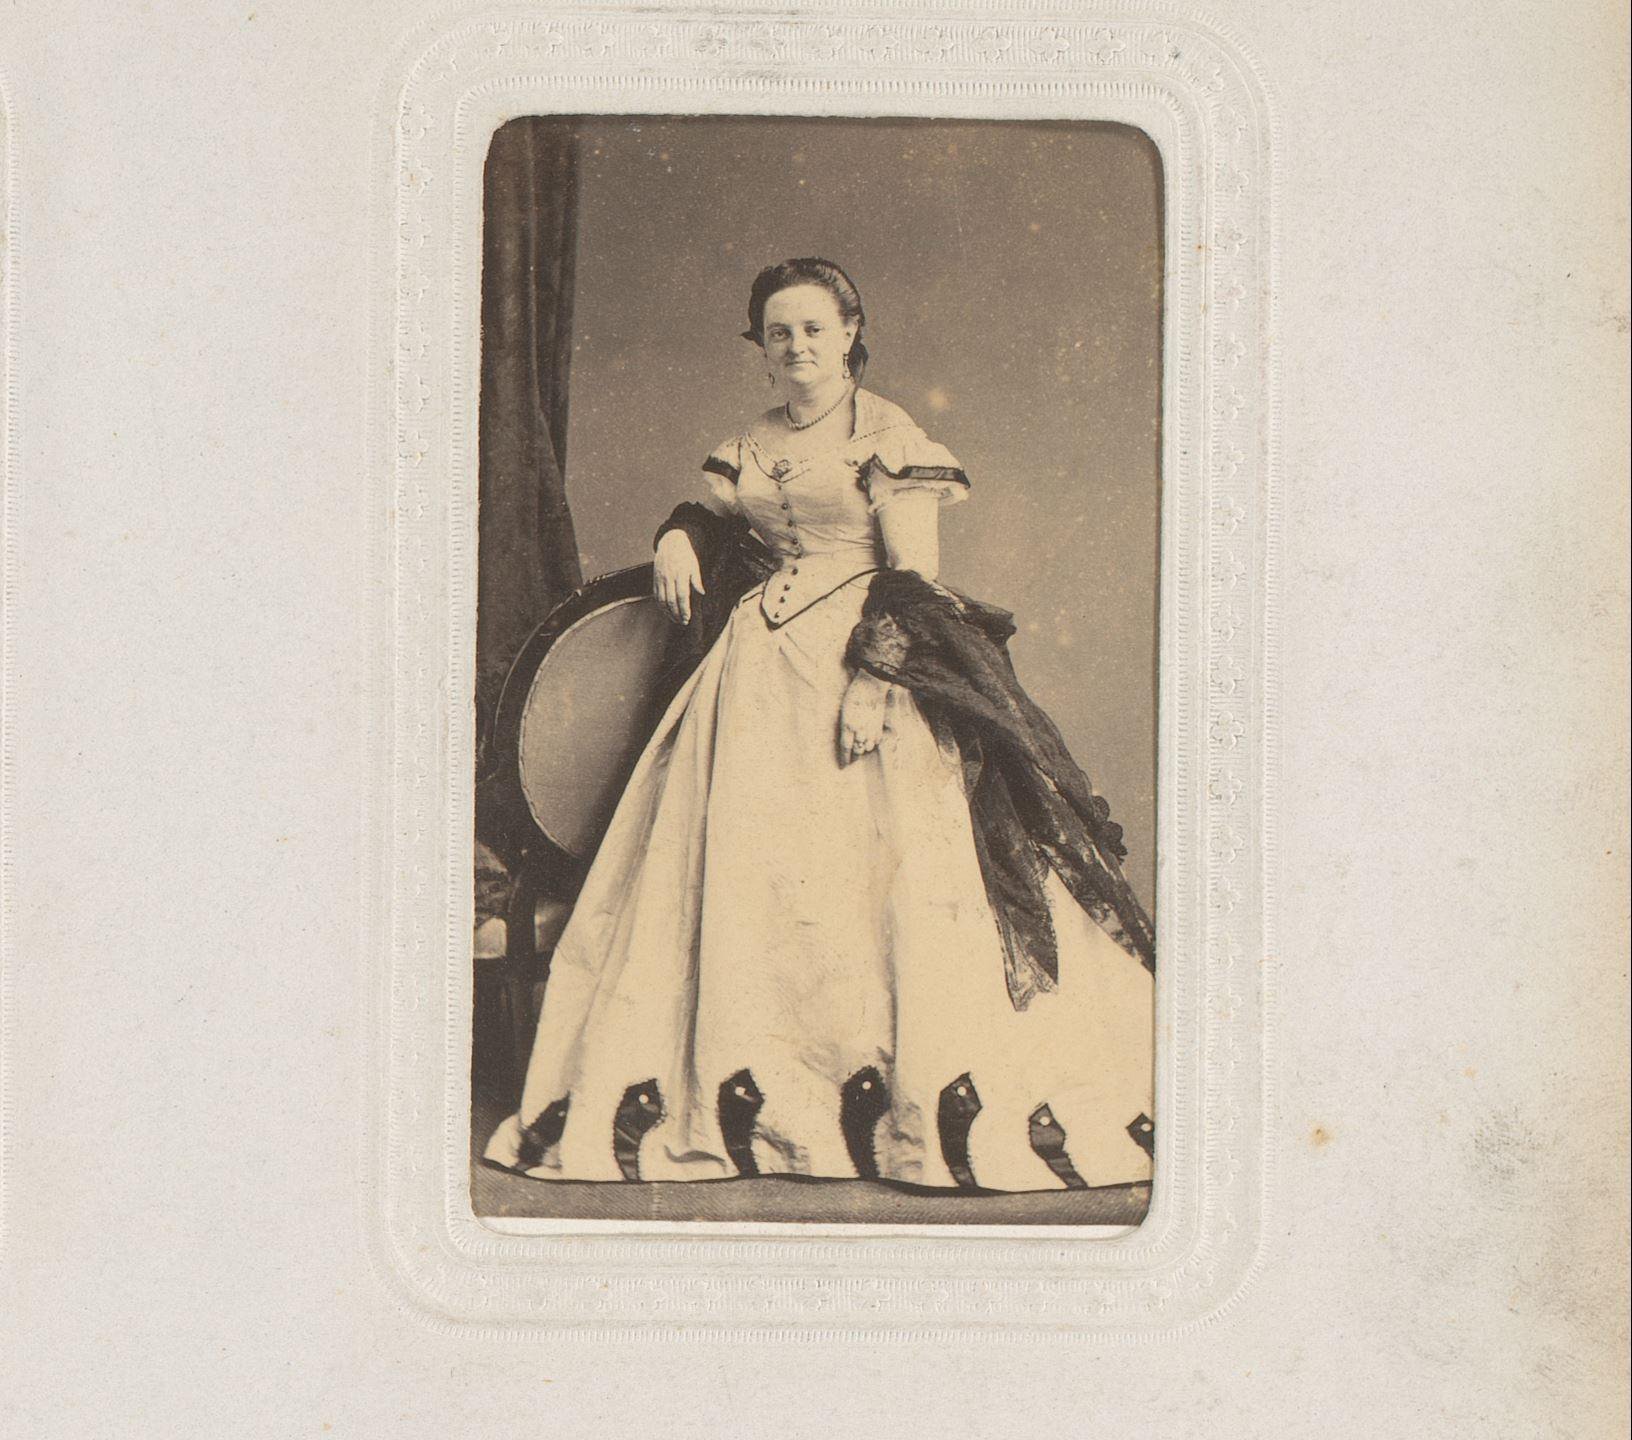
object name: carte de visite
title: Portret van een vrouw met sjaal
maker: samuel a. cohner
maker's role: fotograaf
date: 1860-1890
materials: cardboard, photographic support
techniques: albumen print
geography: havana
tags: historical persons - bb - woman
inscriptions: inscription: ‘S.A. Cohner/ O'Reilly No 62/ Entre Habana y Compostela/ Habana’